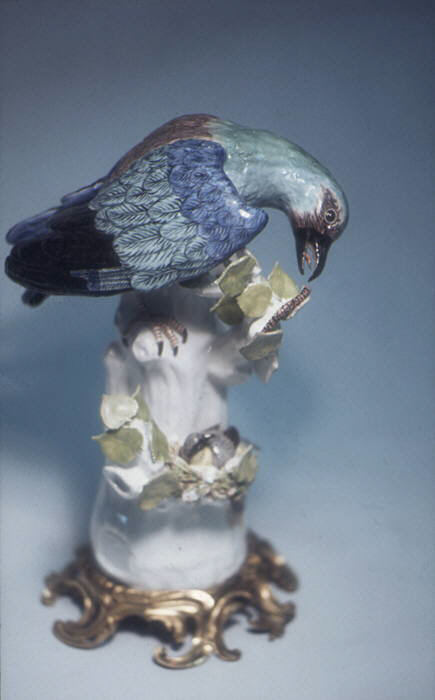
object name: figure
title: Roller (one of a pair)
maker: meissen manufactory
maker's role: manufactory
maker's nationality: german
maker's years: 1710-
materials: gilt bronze, hard paste porcelain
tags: birds